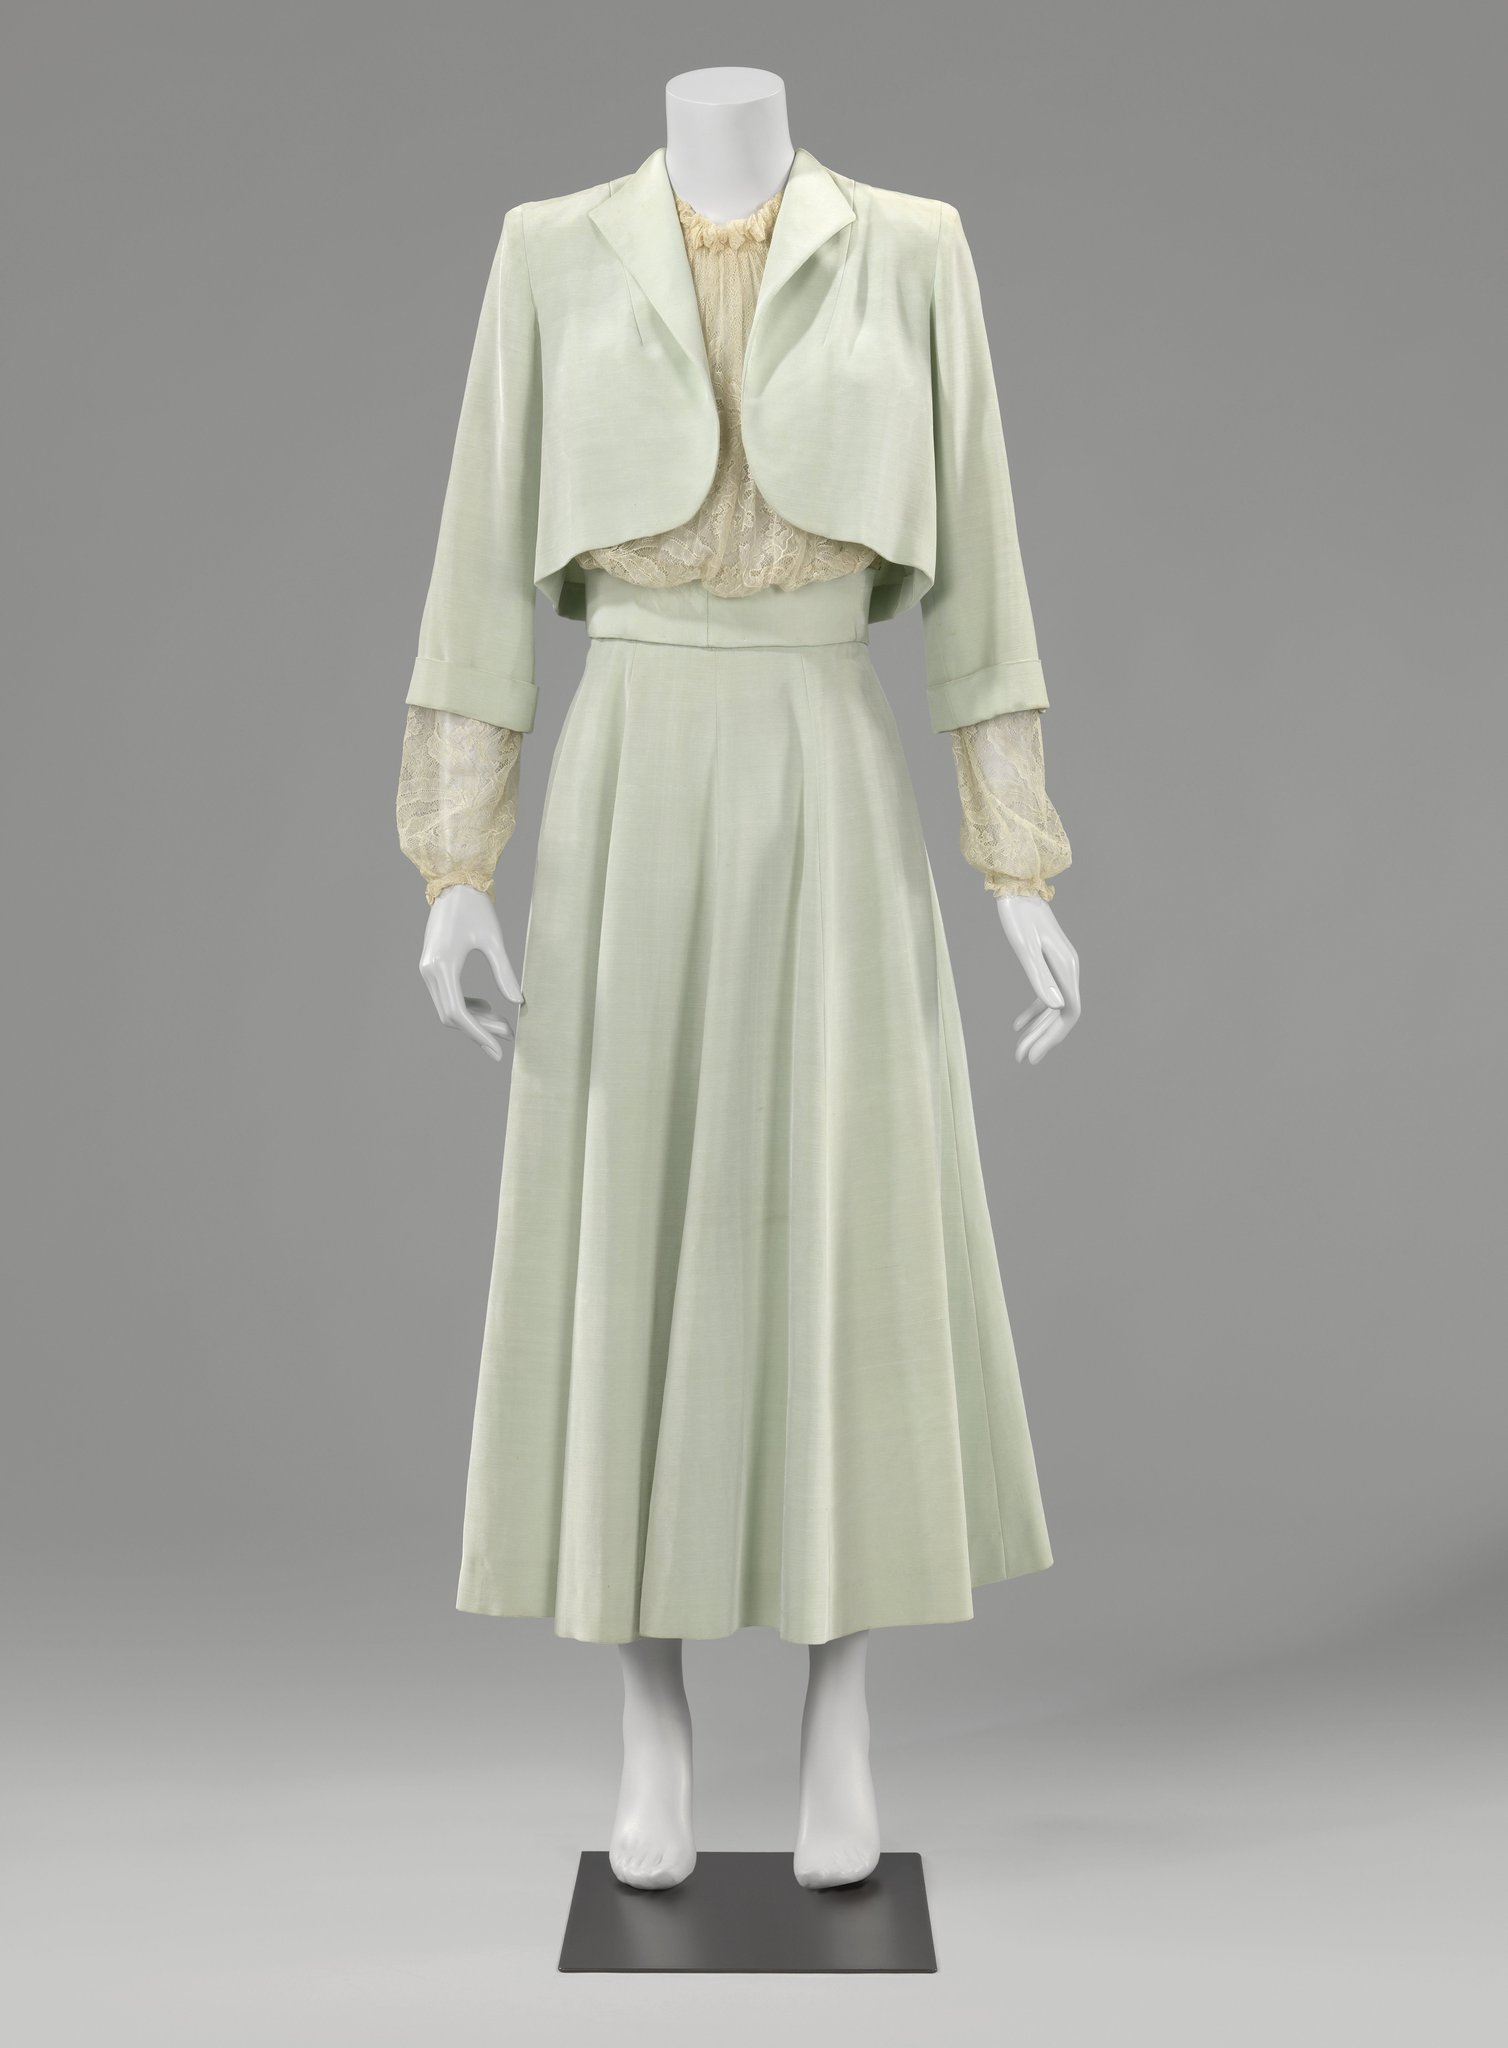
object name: wedding clothes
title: Jasje met wijde 7/8 mouwen met omslag, lange reverskraag langs voorpanden en brede schouders met schouderkappen van lichtgroene geribde moiré-zijde; voor hoger dan achter.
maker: mevrouw stapelveld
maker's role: linnennaaister, naaister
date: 1948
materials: textile, silk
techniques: moire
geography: netherlands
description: Kort bolero-achtig jasje van een mantelpak met wijde 7/8 mouwen met teruggeslagen manchet. Geen kraag langs de hals, lange reverskraag langs voorpanden. Brede schouders met schouderkappen. Jasje van lichtgroene geribde moiré satijn.